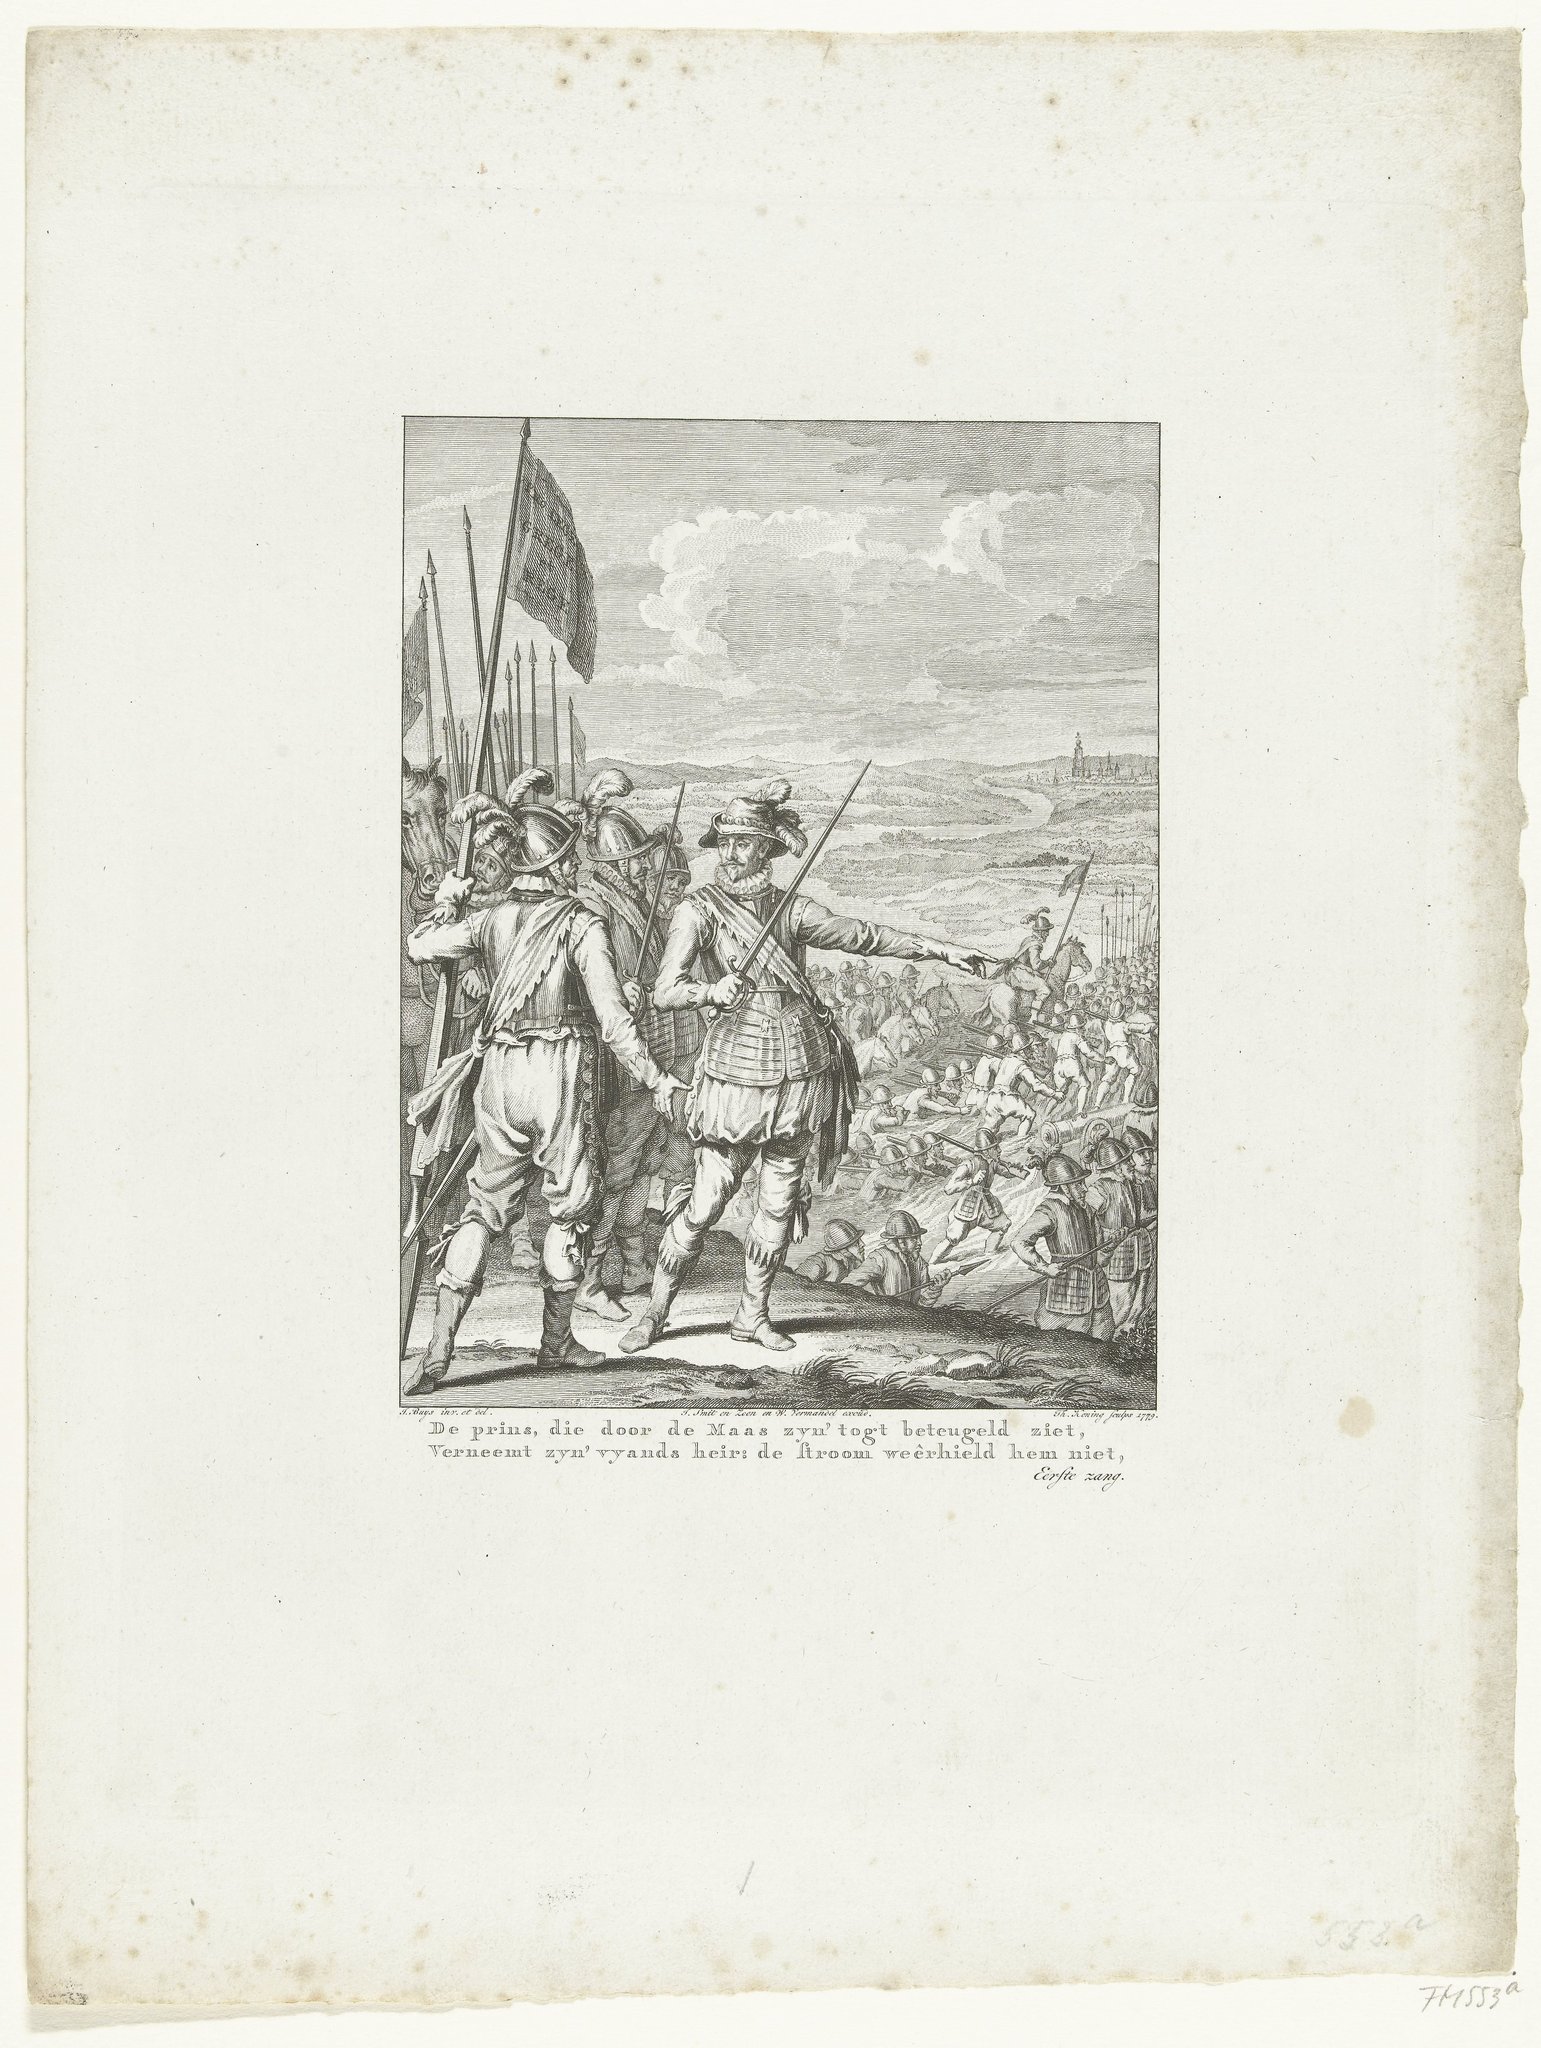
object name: print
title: De prins, die door de Maas zyn' togt beteugeld ziet, Verneemt zyn' vyands heir: de stroom weêrhield hem niet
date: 1779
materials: paper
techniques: etching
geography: amsterdam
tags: delft, william i (prince of orange), maastricht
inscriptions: date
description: Illustratie voor: J. Nomsz, Willem de eerste, of de grondlegging der Nederlandsche vryheid. : In vier en twintig zangen, Erven van David Klippink, Amsterdam 1779. Staat met de letter.